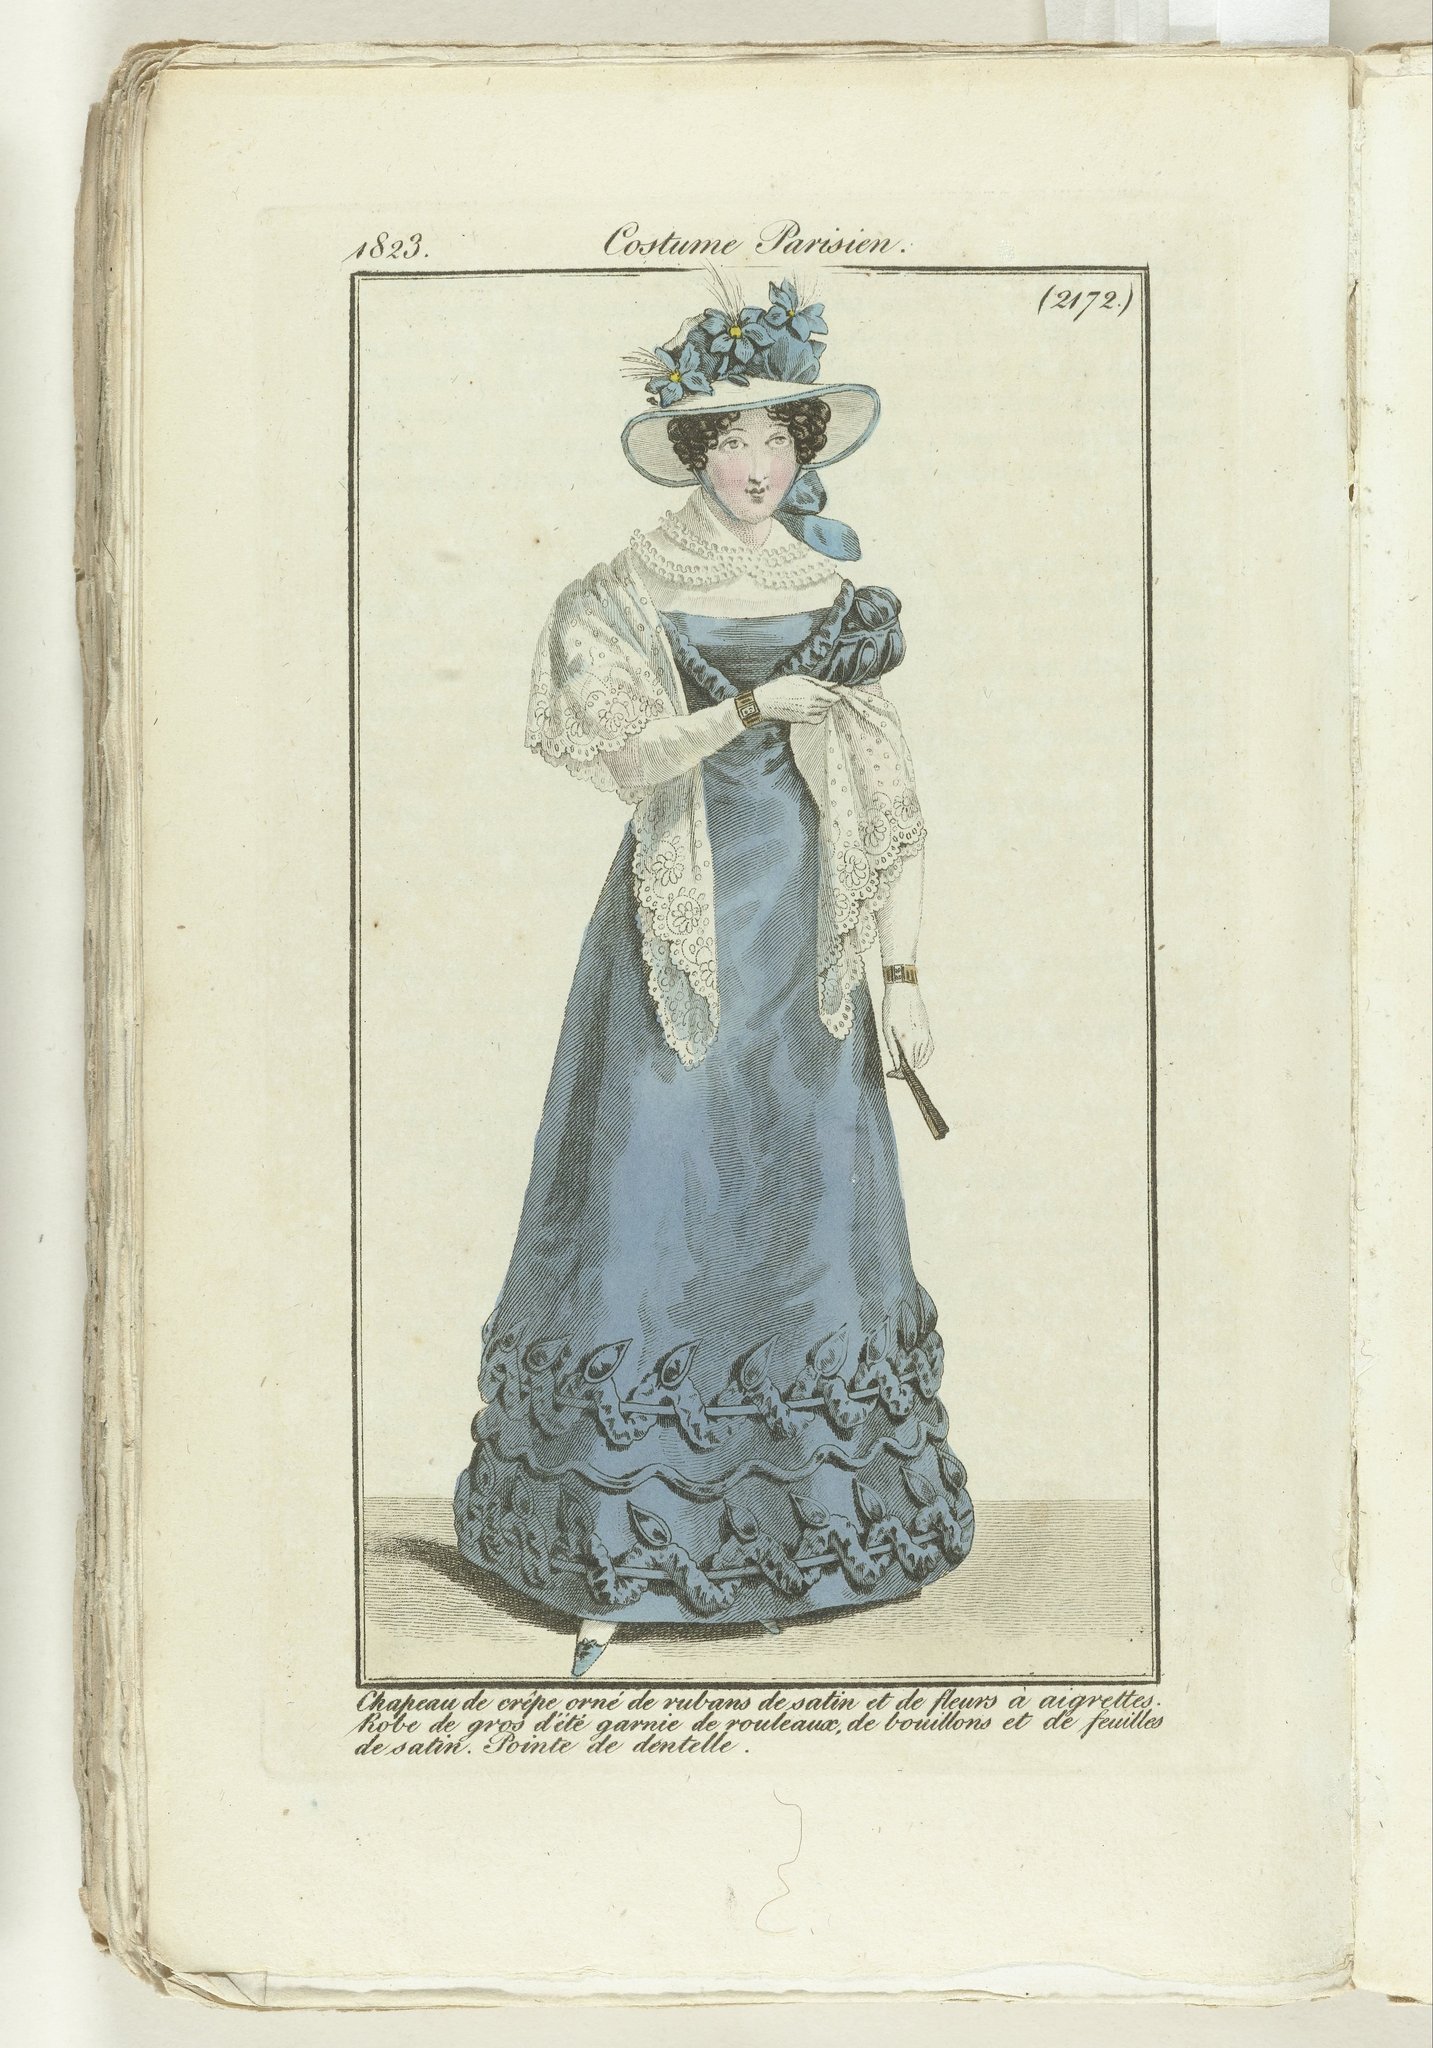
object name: fashion print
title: Journal des Dames et des Modes 1823, Costume Parisien (2172)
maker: Anonymous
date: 1823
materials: paper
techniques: etching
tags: fashion plates, clothes, costume (+ women's clothes)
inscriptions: date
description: Prent uit het tijdschrift Journal des Dames et des Modes, 1823.